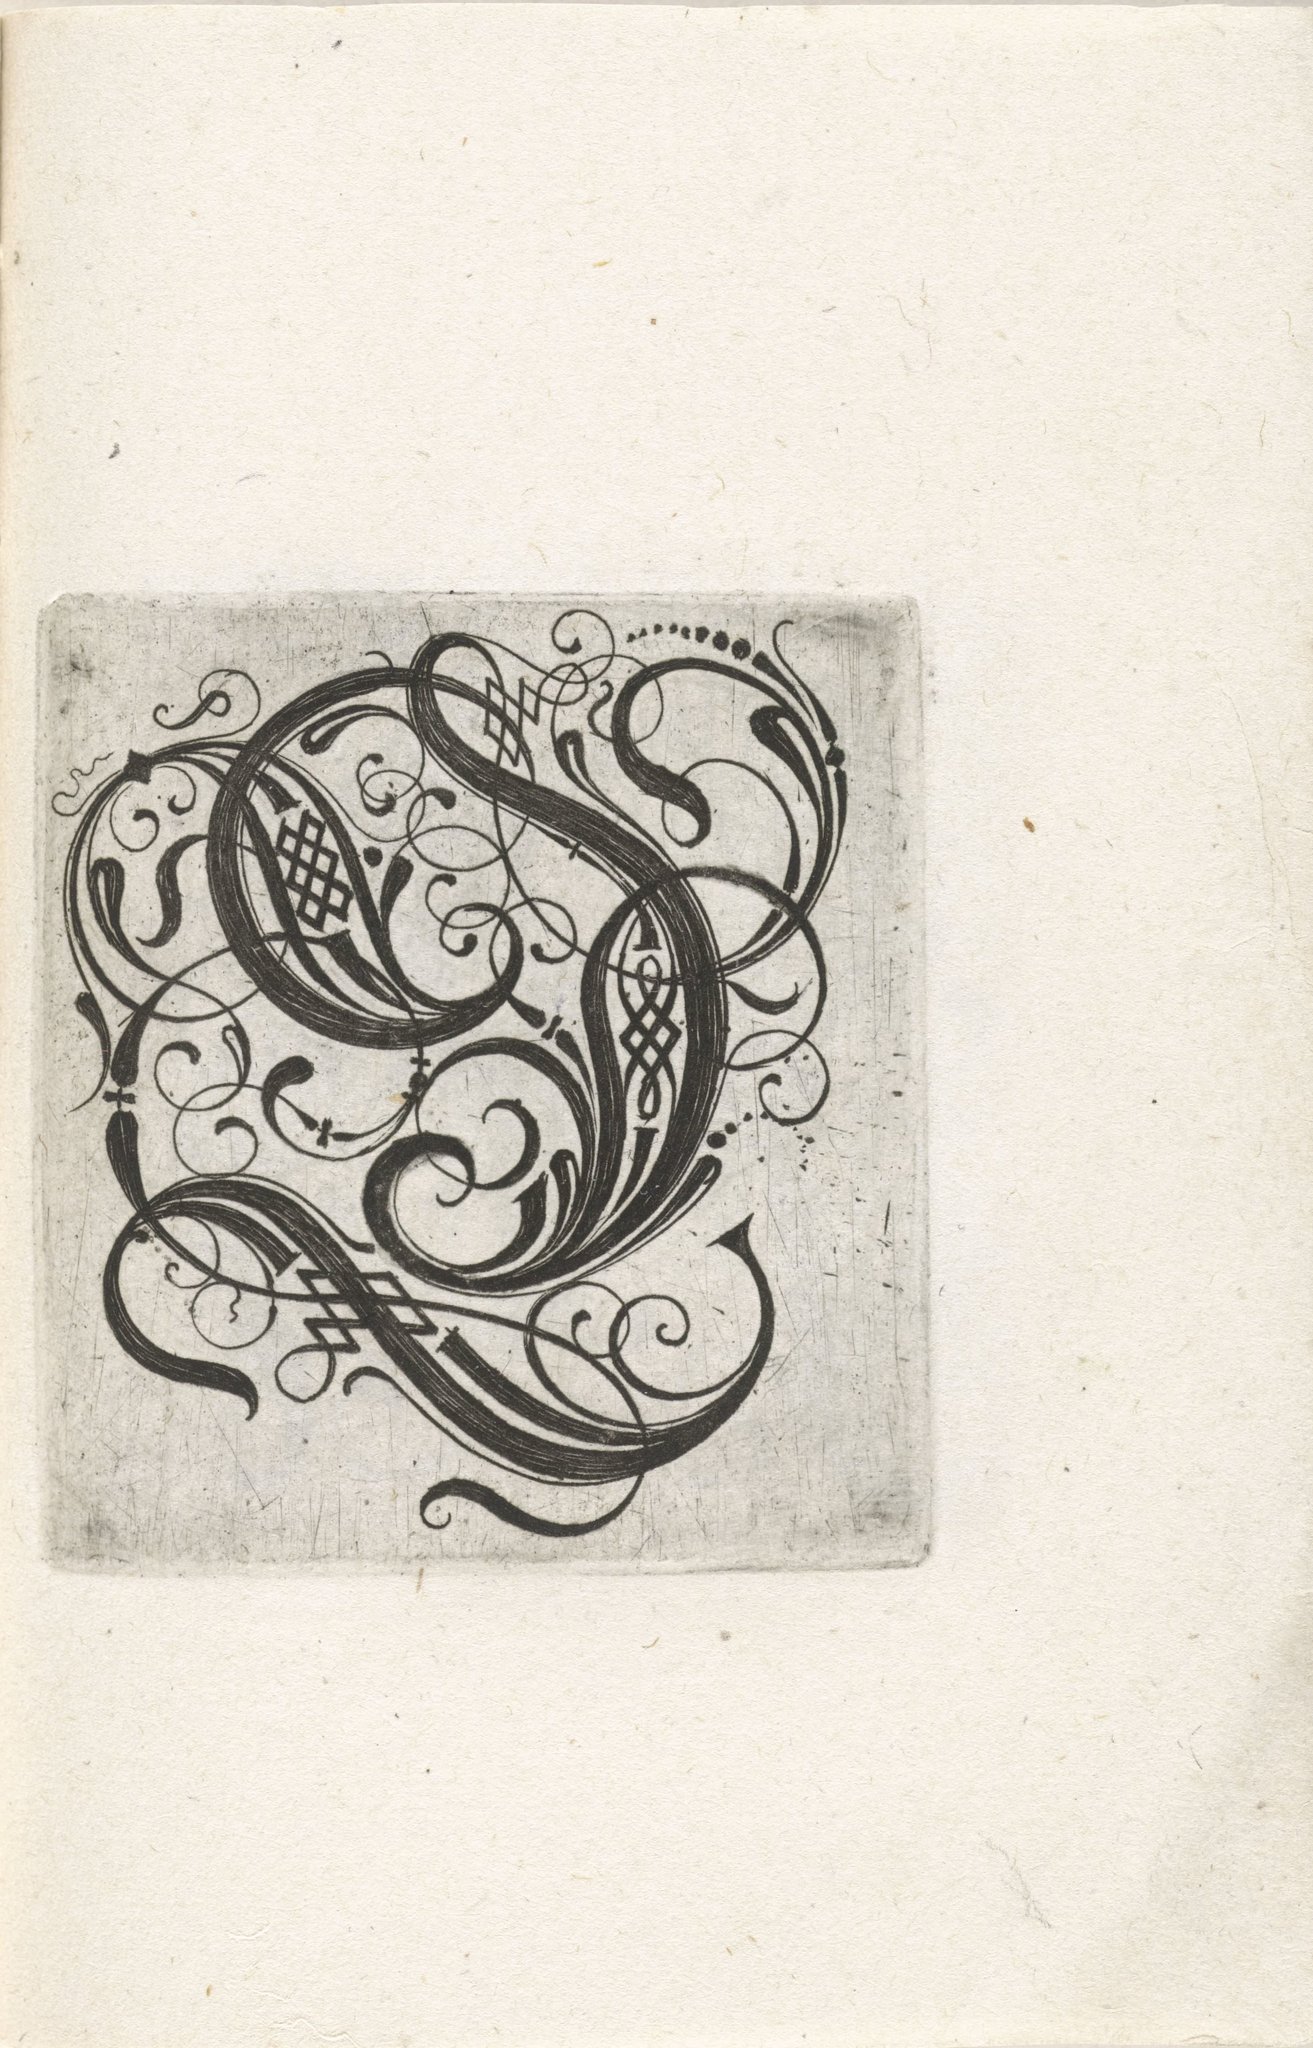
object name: print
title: Alfabet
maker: Anonymous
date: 1600-1699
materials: paper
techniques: engraving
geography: netherlands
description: Uit serie van 24 gotische letters met vlechtwerk: A-I, K-T en V-Z.